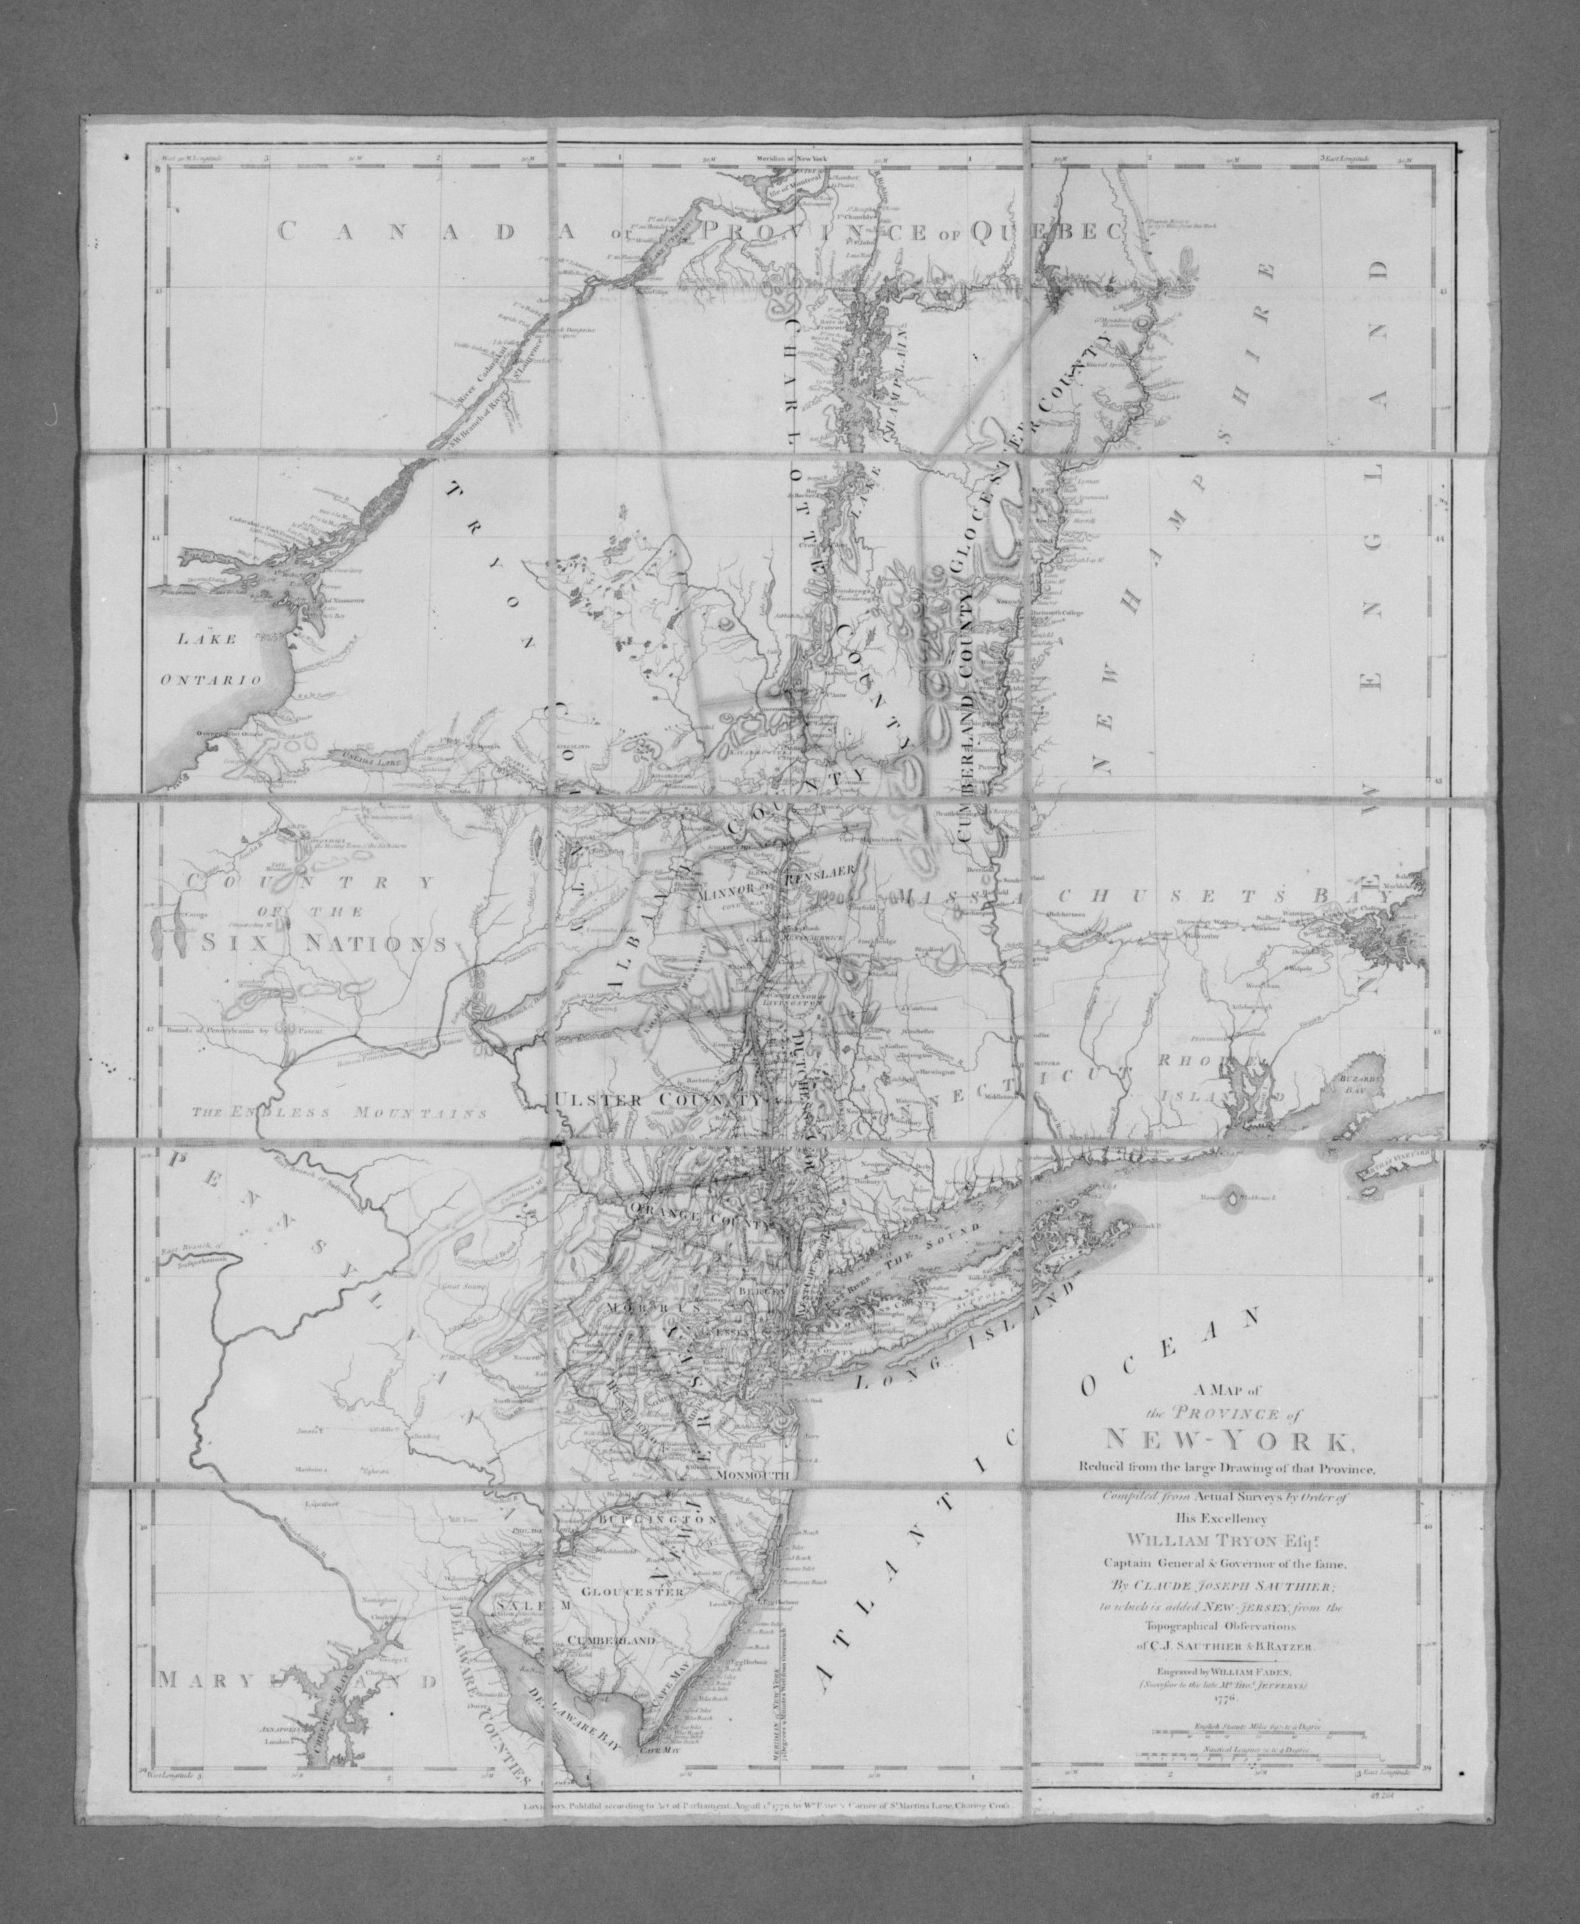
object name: map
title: Map of the Province of New York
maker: william faden the younger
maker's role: maker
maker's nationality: british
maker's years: 1749-1836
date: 1776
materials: canvas, ink, paper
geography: england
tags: maps,new york city